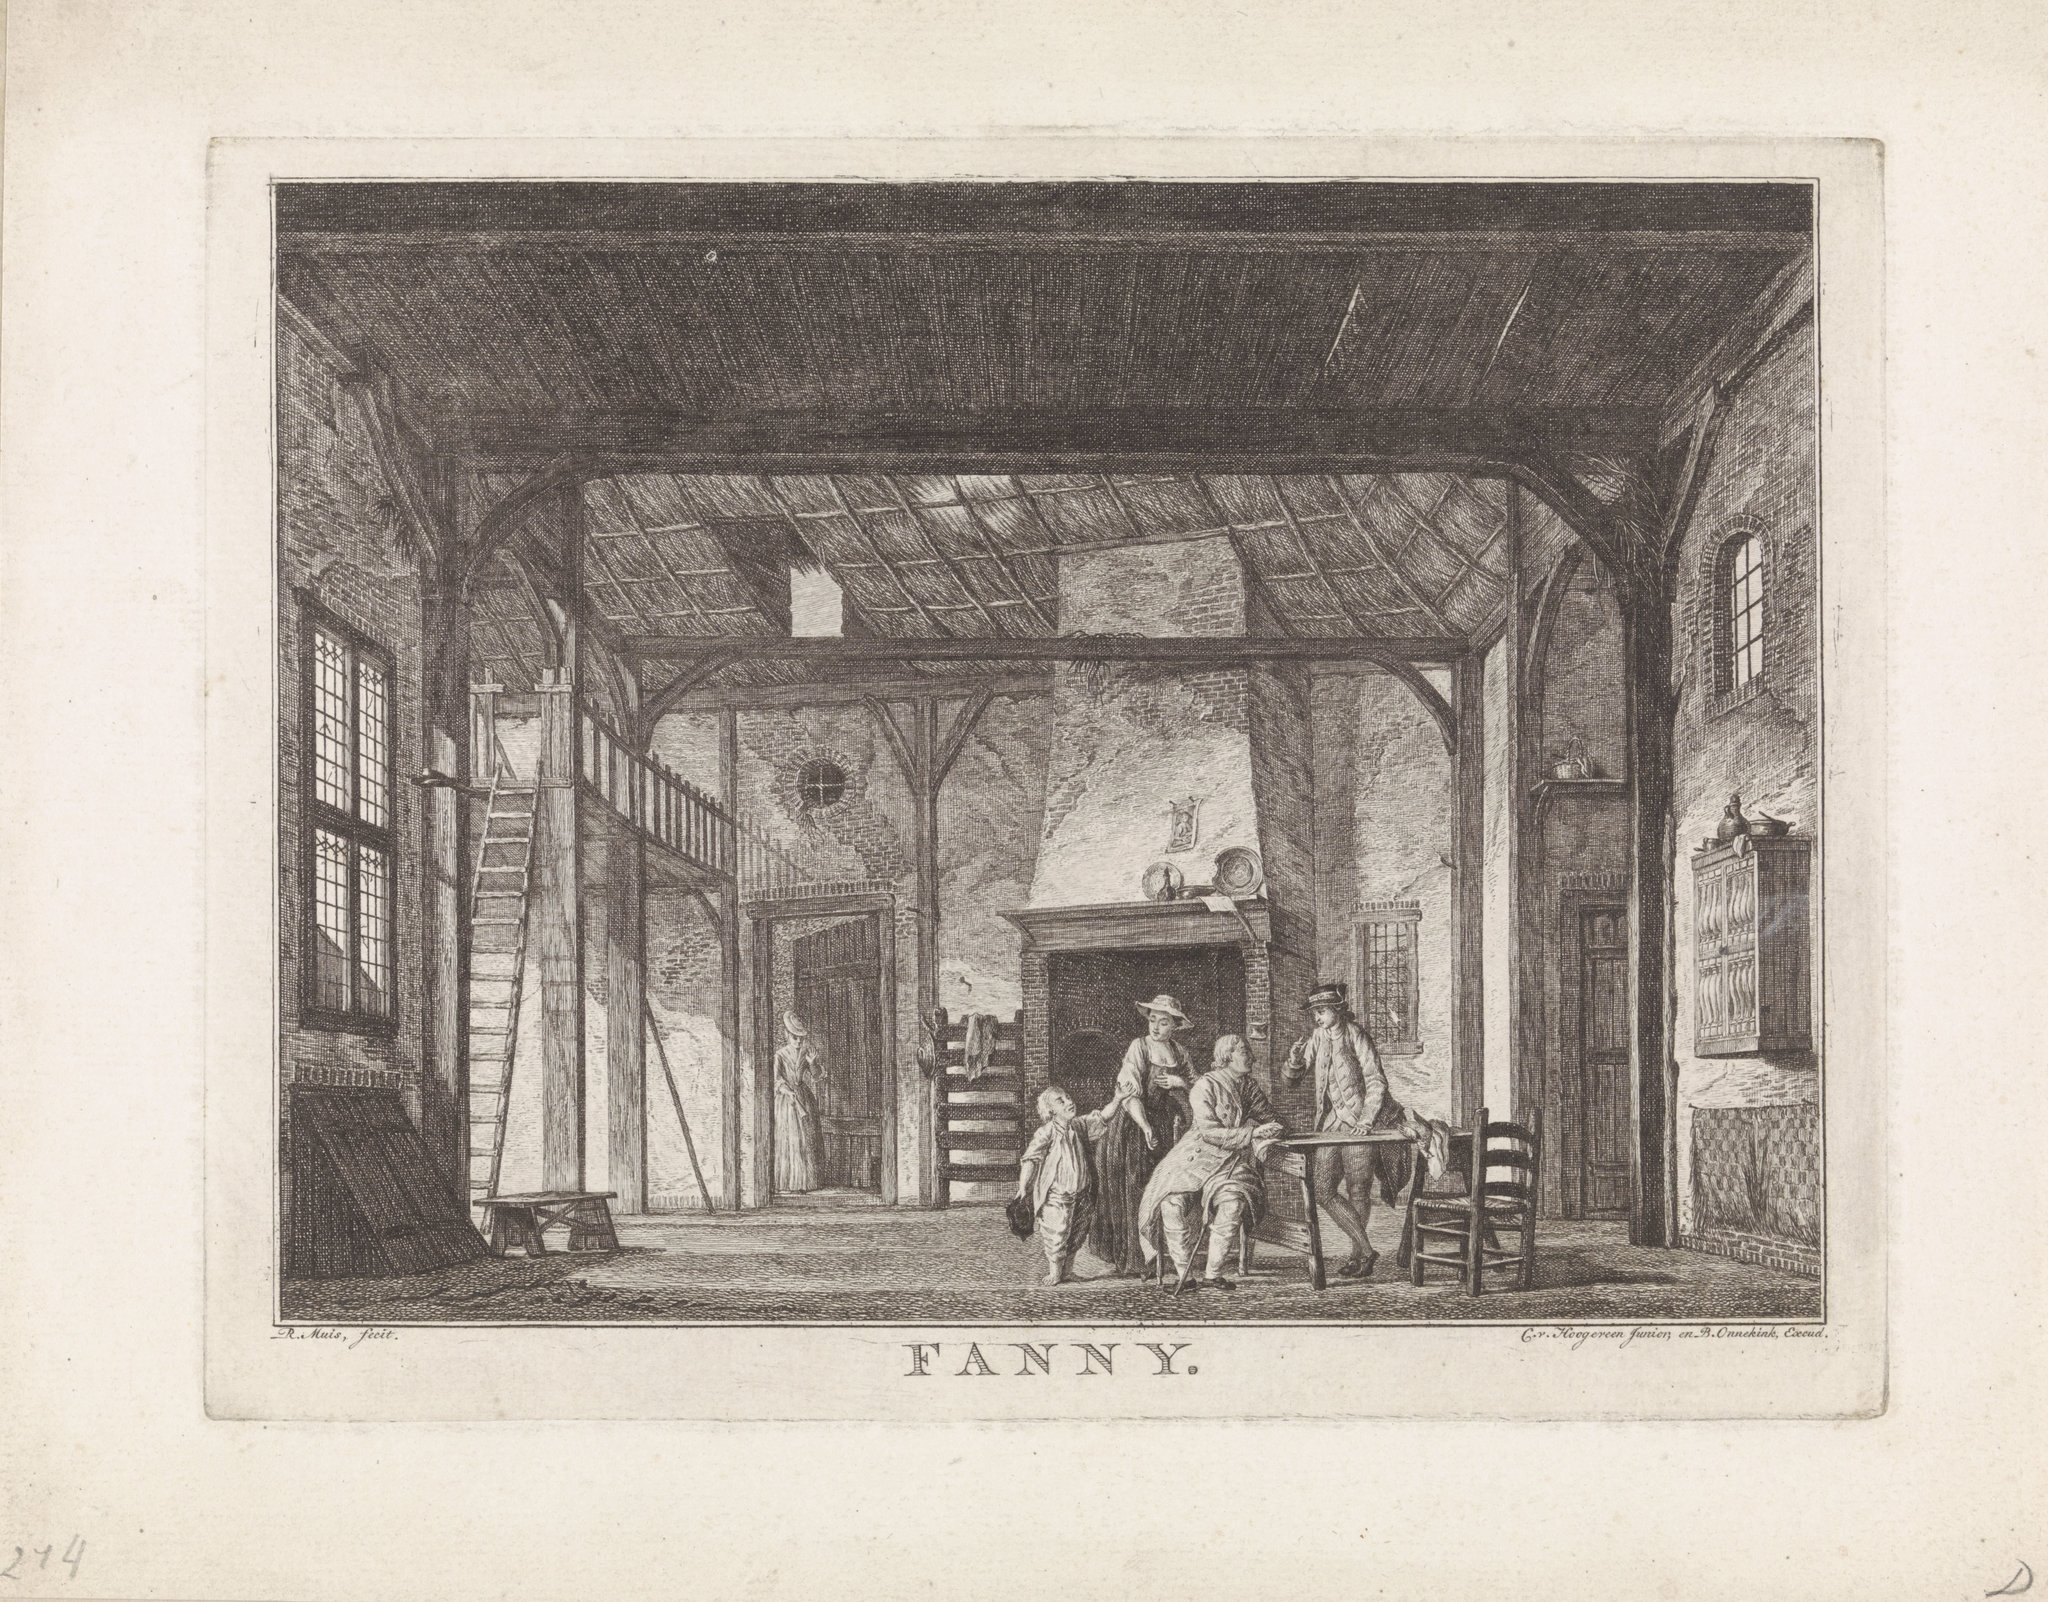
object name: print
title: Fanny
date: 1770-1825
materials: paper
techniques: etching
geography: leiden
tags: theatre, theatrical performance, hotel, hostelry, inn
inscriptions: collector's mark: Lugt 2233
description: In een herberg, voor een schouw, staan een man, vrouw en een kind, één man zit. Linksachter betreedt een vrouw de kamer. De prent verbeeldt een toneelscène uit Fanny, of Het gelukkig berouw, een toneelstuk van François Thomas Marie de Baculard d'Arnaud.